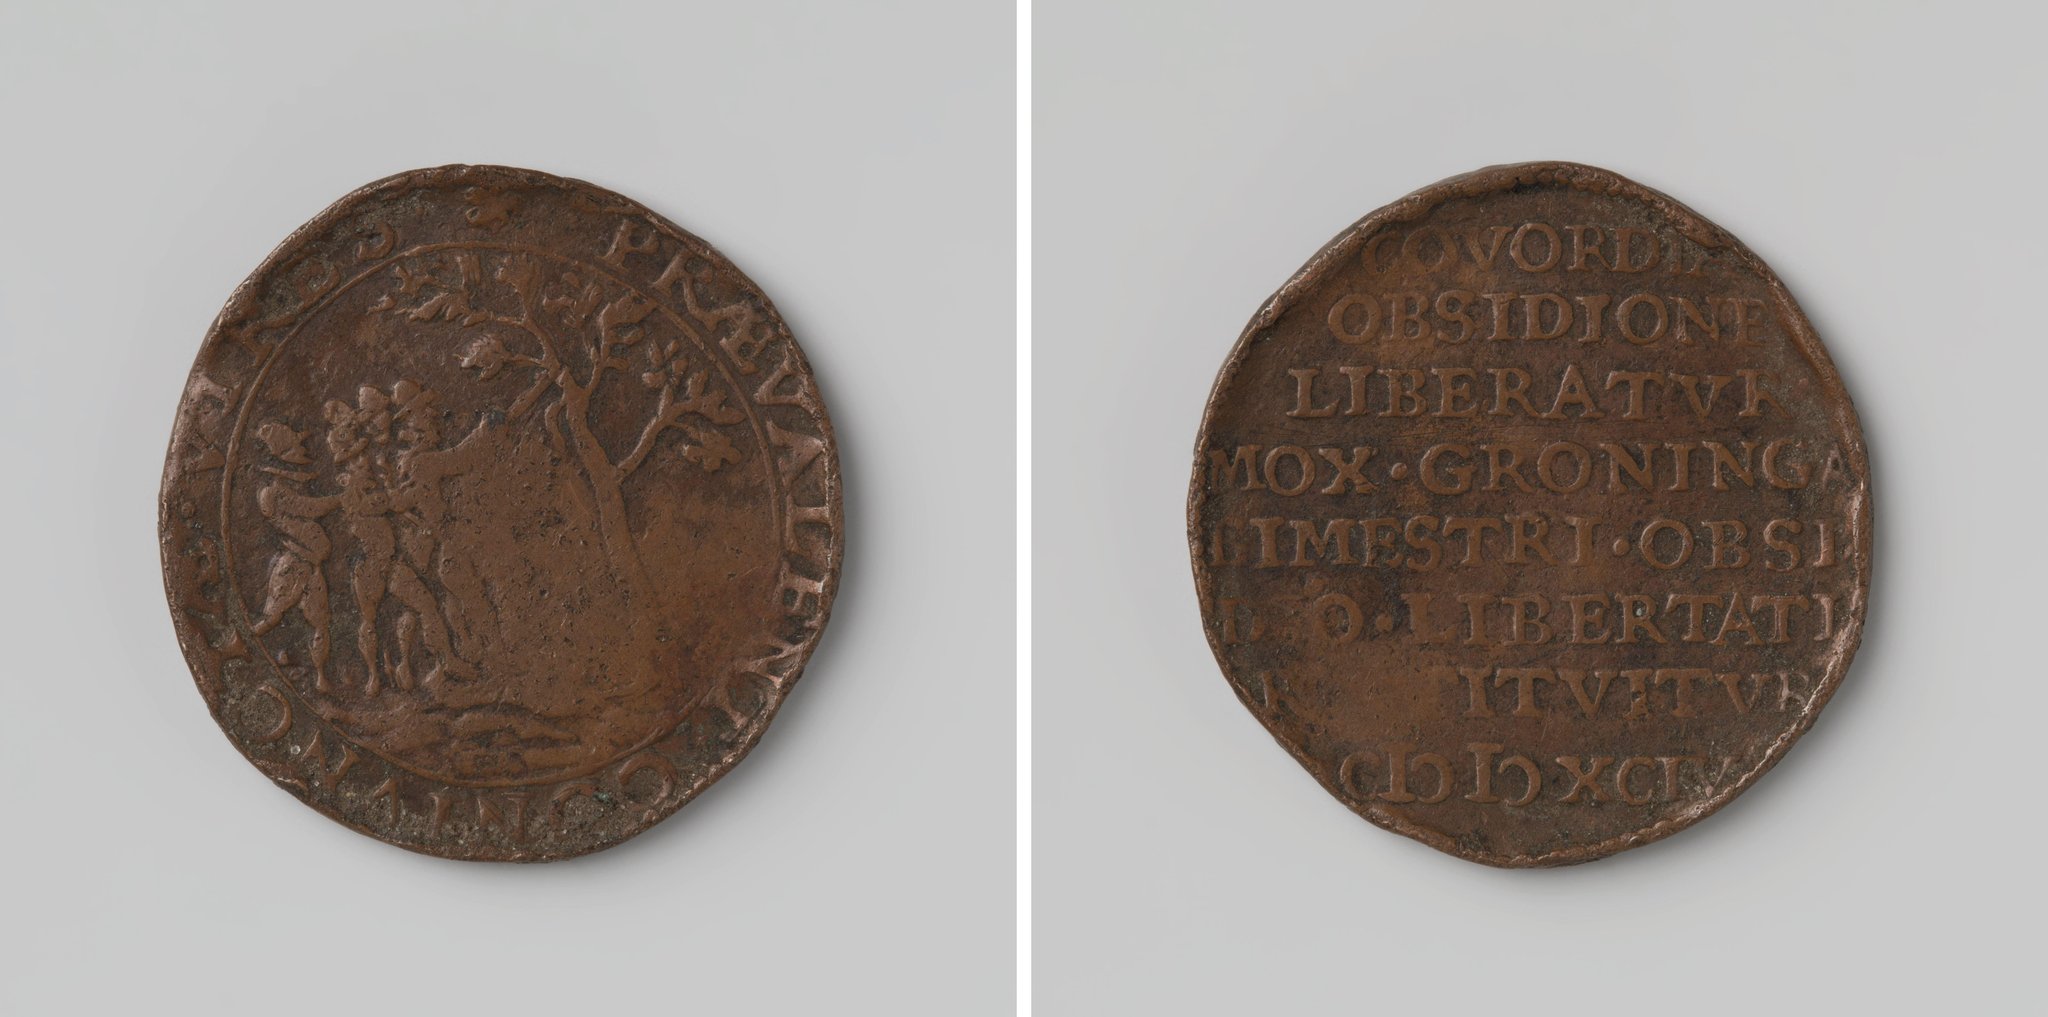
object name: jeton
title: Ontzet van Coevorden en reductie van Groningen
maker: Anonymous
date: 1594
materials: copper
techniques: striking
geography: dordrecht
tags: the hague, maurice (prince of orange)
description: Koperen penning. Voorzijde: vijf mannen proberen gezamelijk een boom omver te trekken binnen omschrift. Keerzijde: opschrift